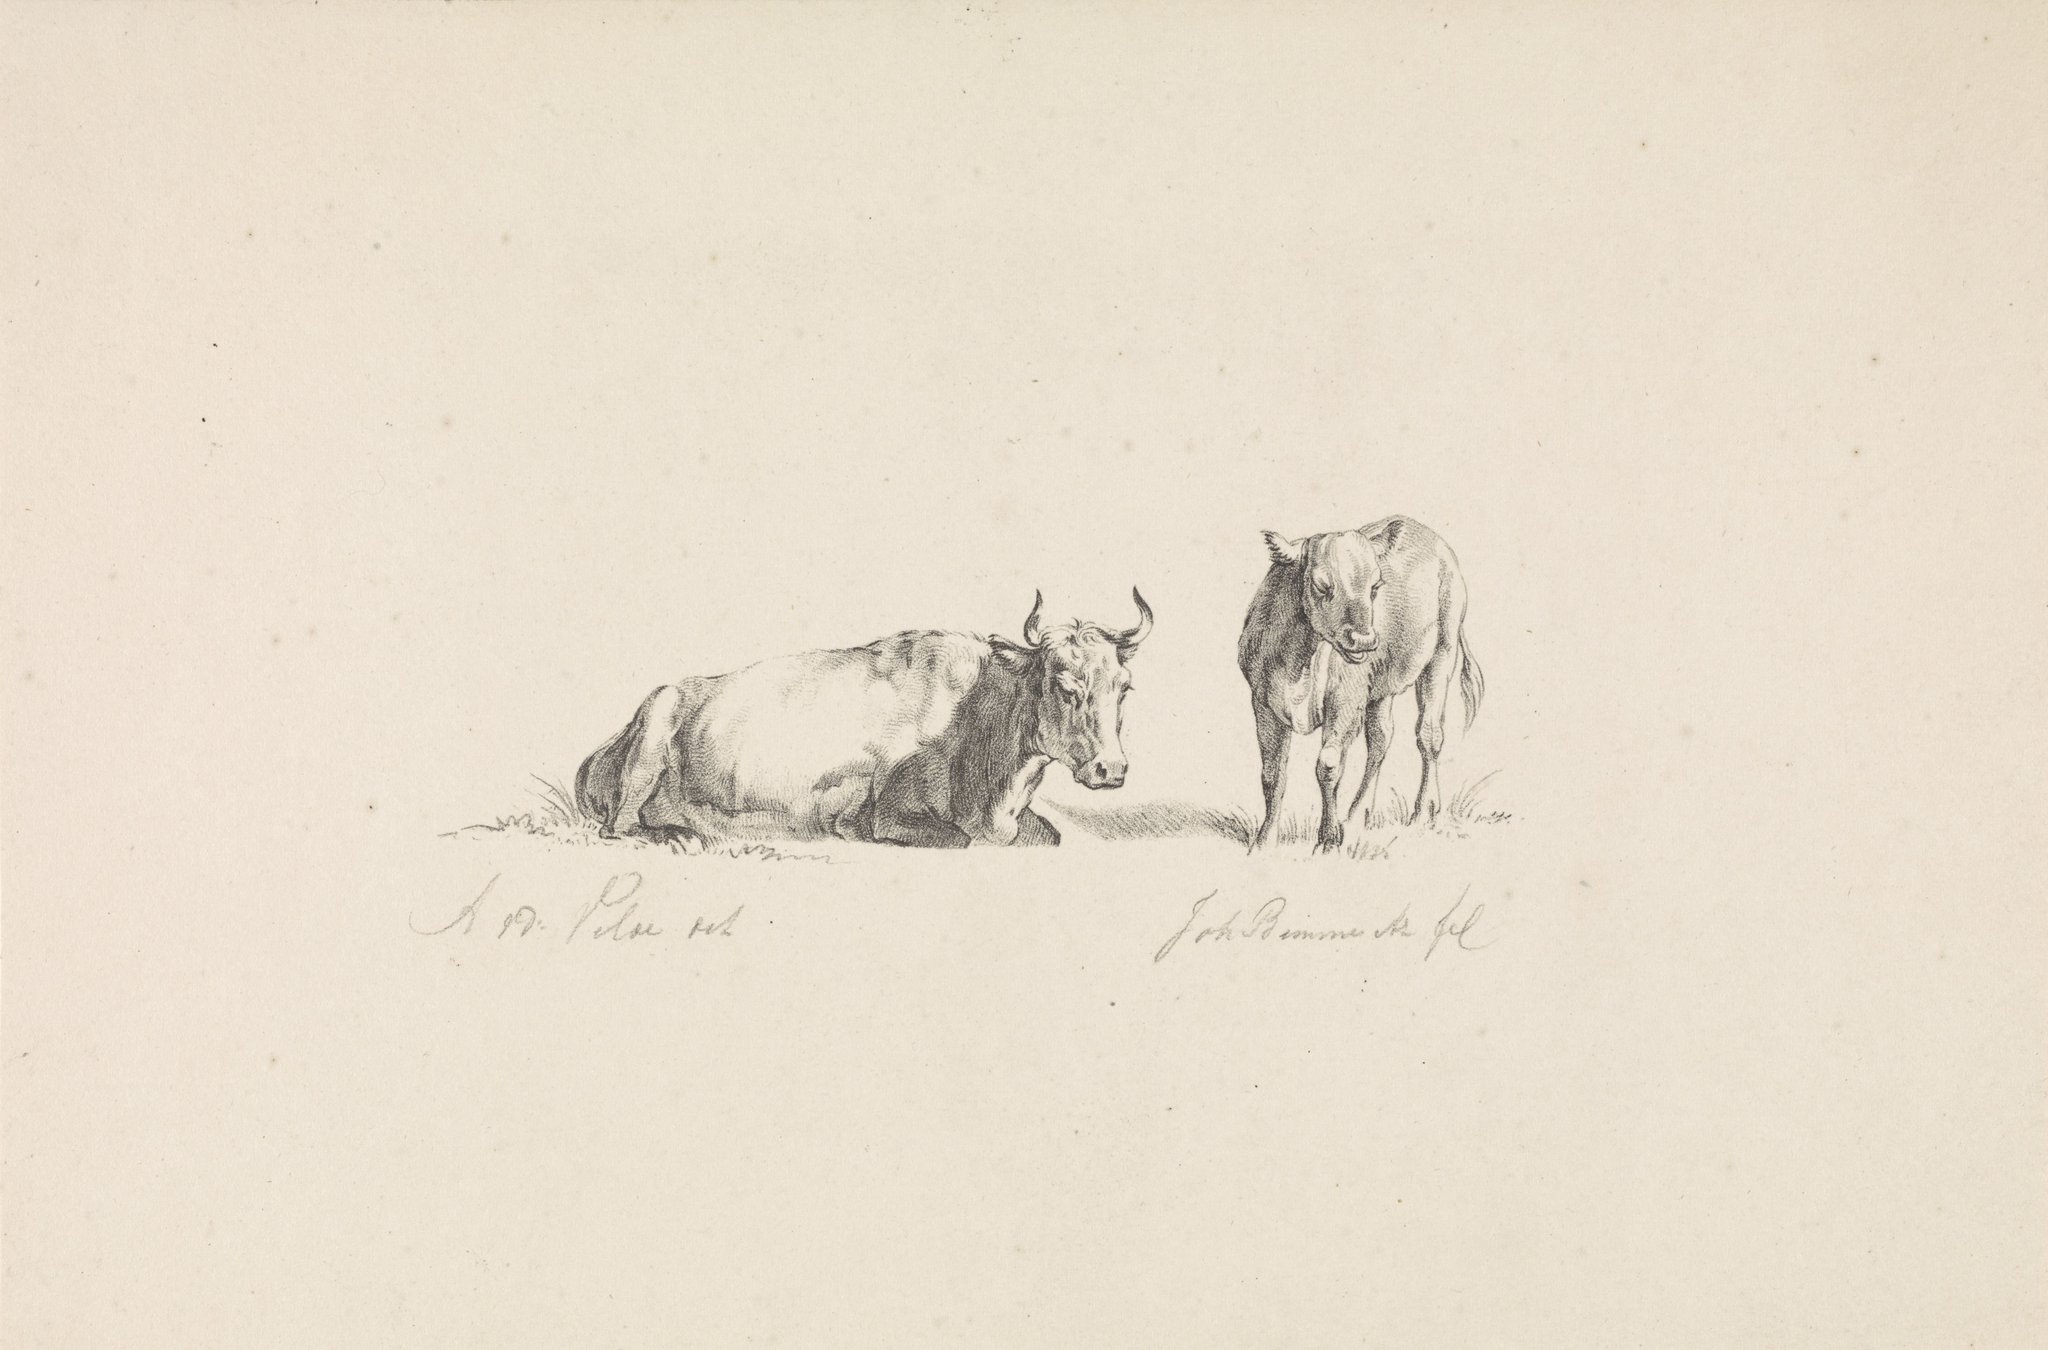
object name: print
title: Stier en een kalf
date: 1809-1841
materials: paper, pencil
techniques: lithograph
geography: amsterdam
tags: cow, calf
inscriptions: signature: ‘A vd Velde del’, signature: ‘Joh Bemme Az Fec’, collector's mark: Lugt 2228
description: De stier ligt op de grond, het kalf staat ernaast.